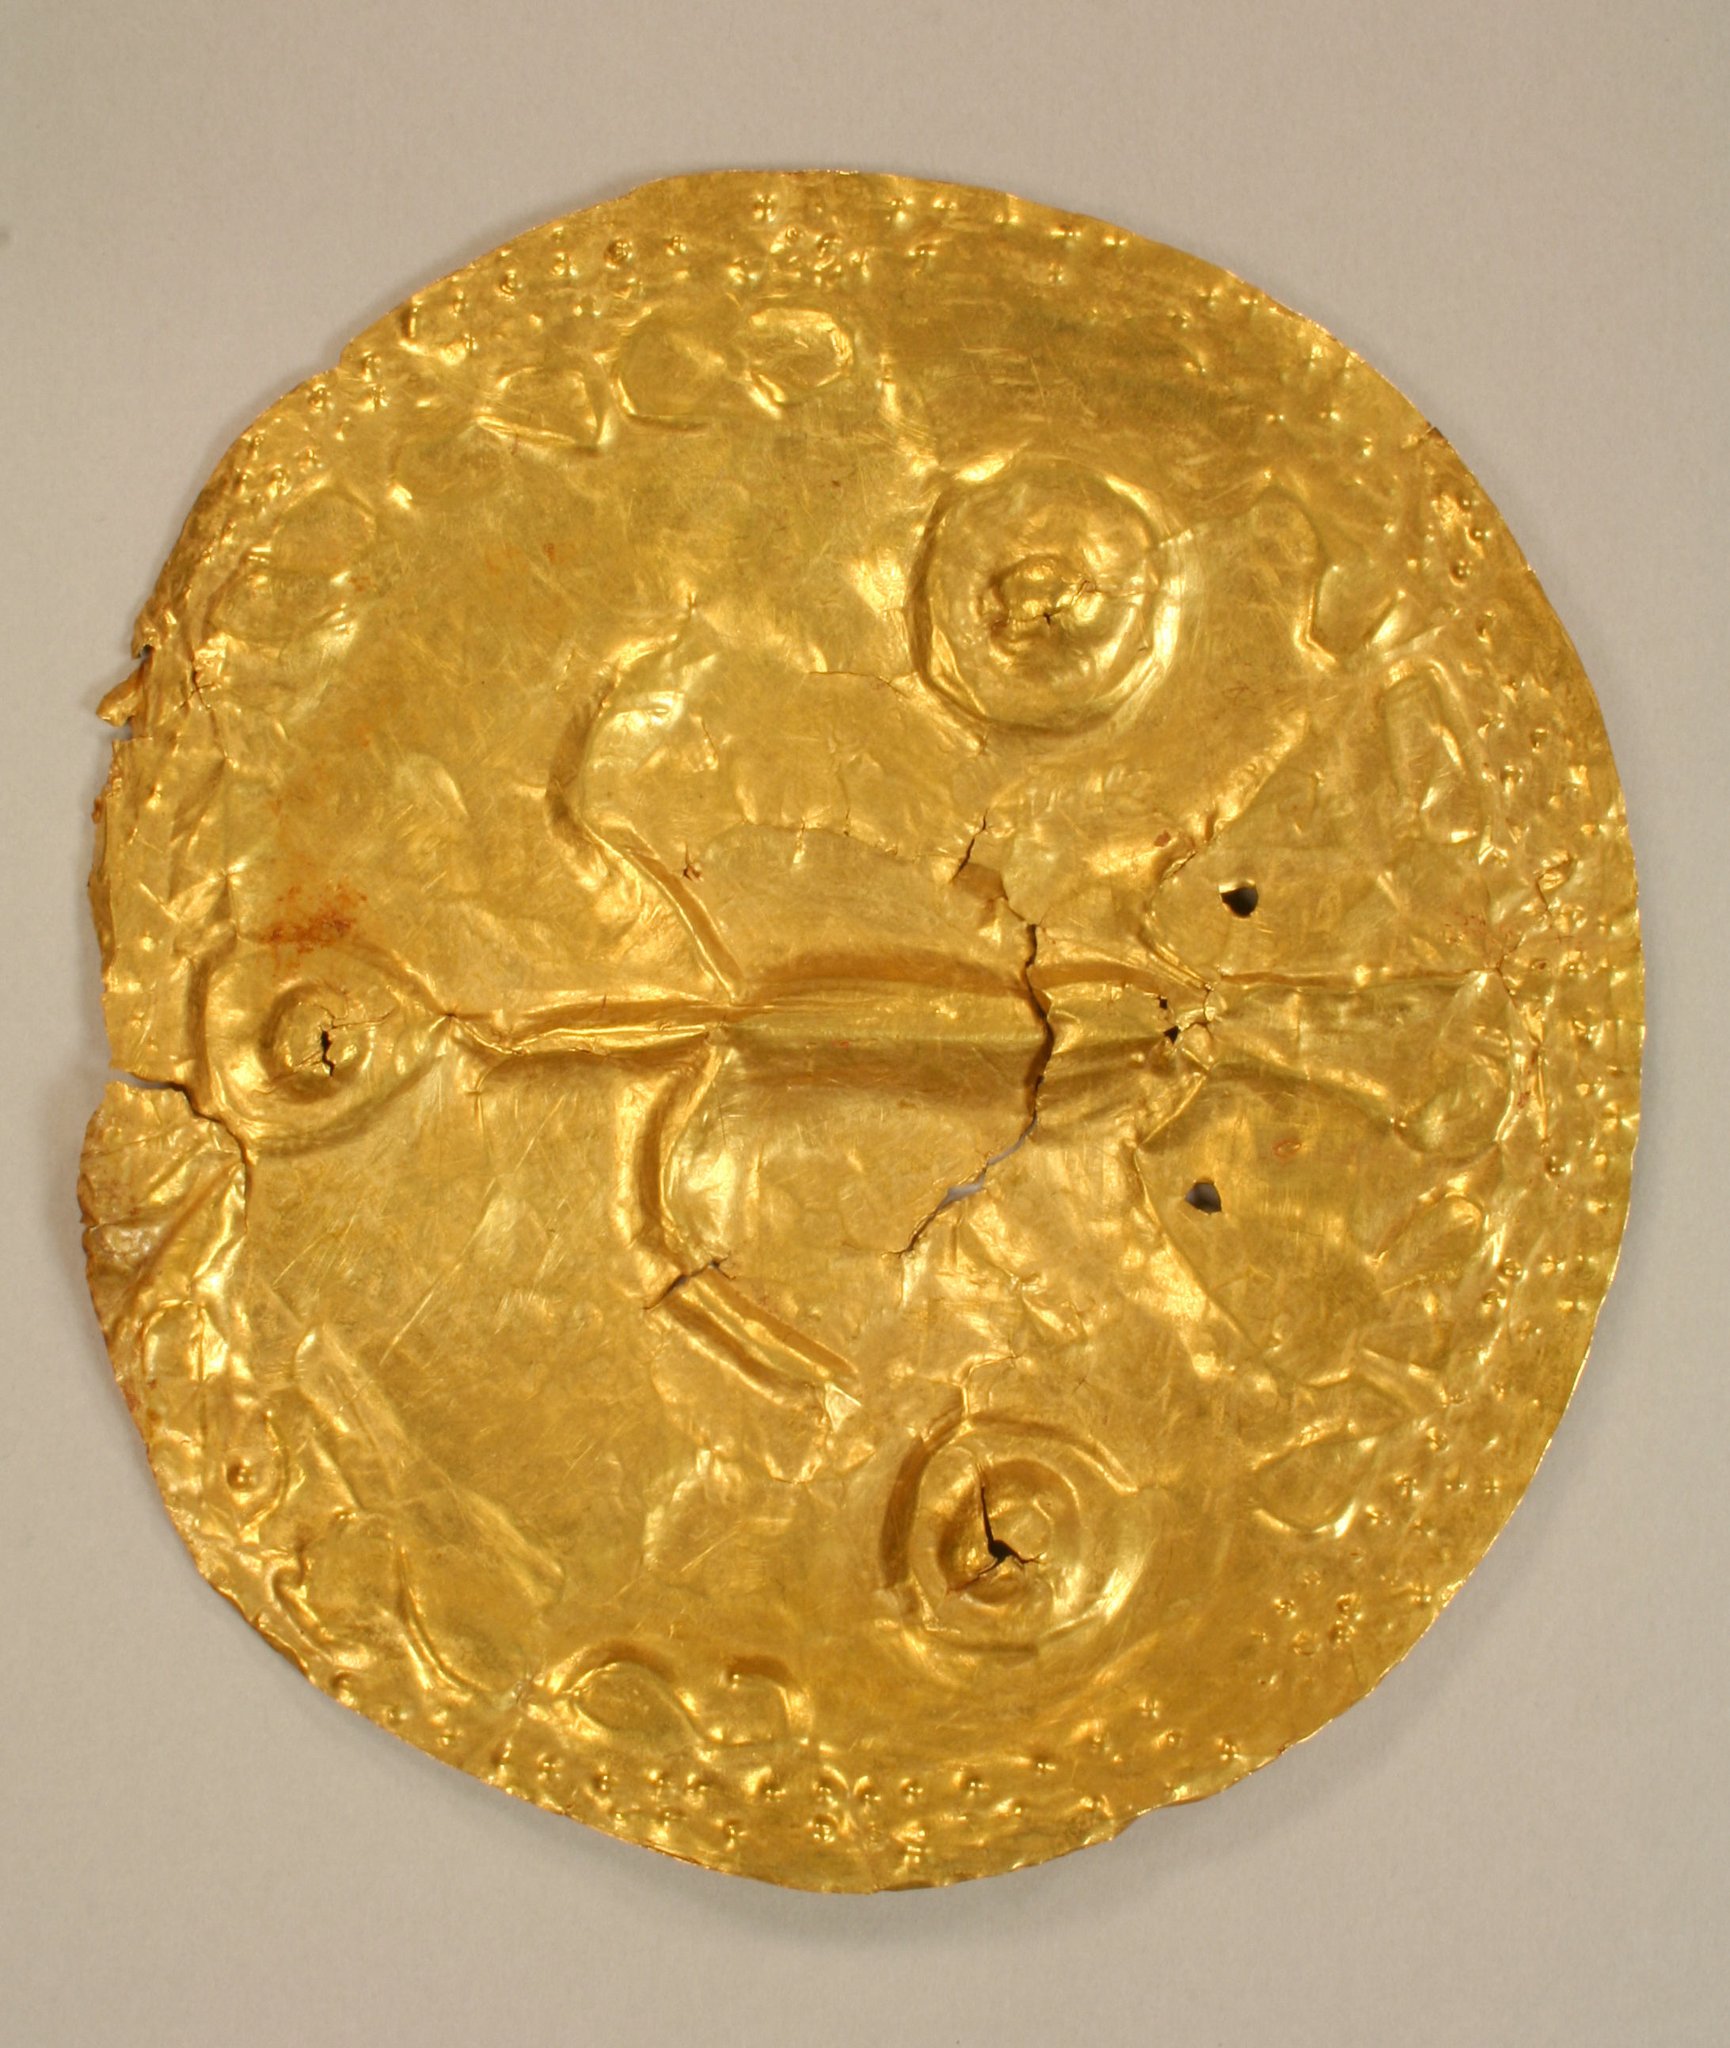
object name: pectoral disk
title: Hammered Gold Patena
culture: costa rican or panamanian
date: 1001-1600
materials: gold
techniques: hammering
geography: costa rica